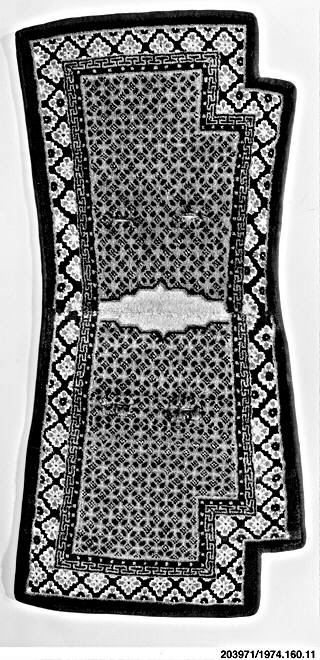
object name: rug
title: Saddle Rug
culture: chinese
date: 1801-1900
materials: cotton, wool